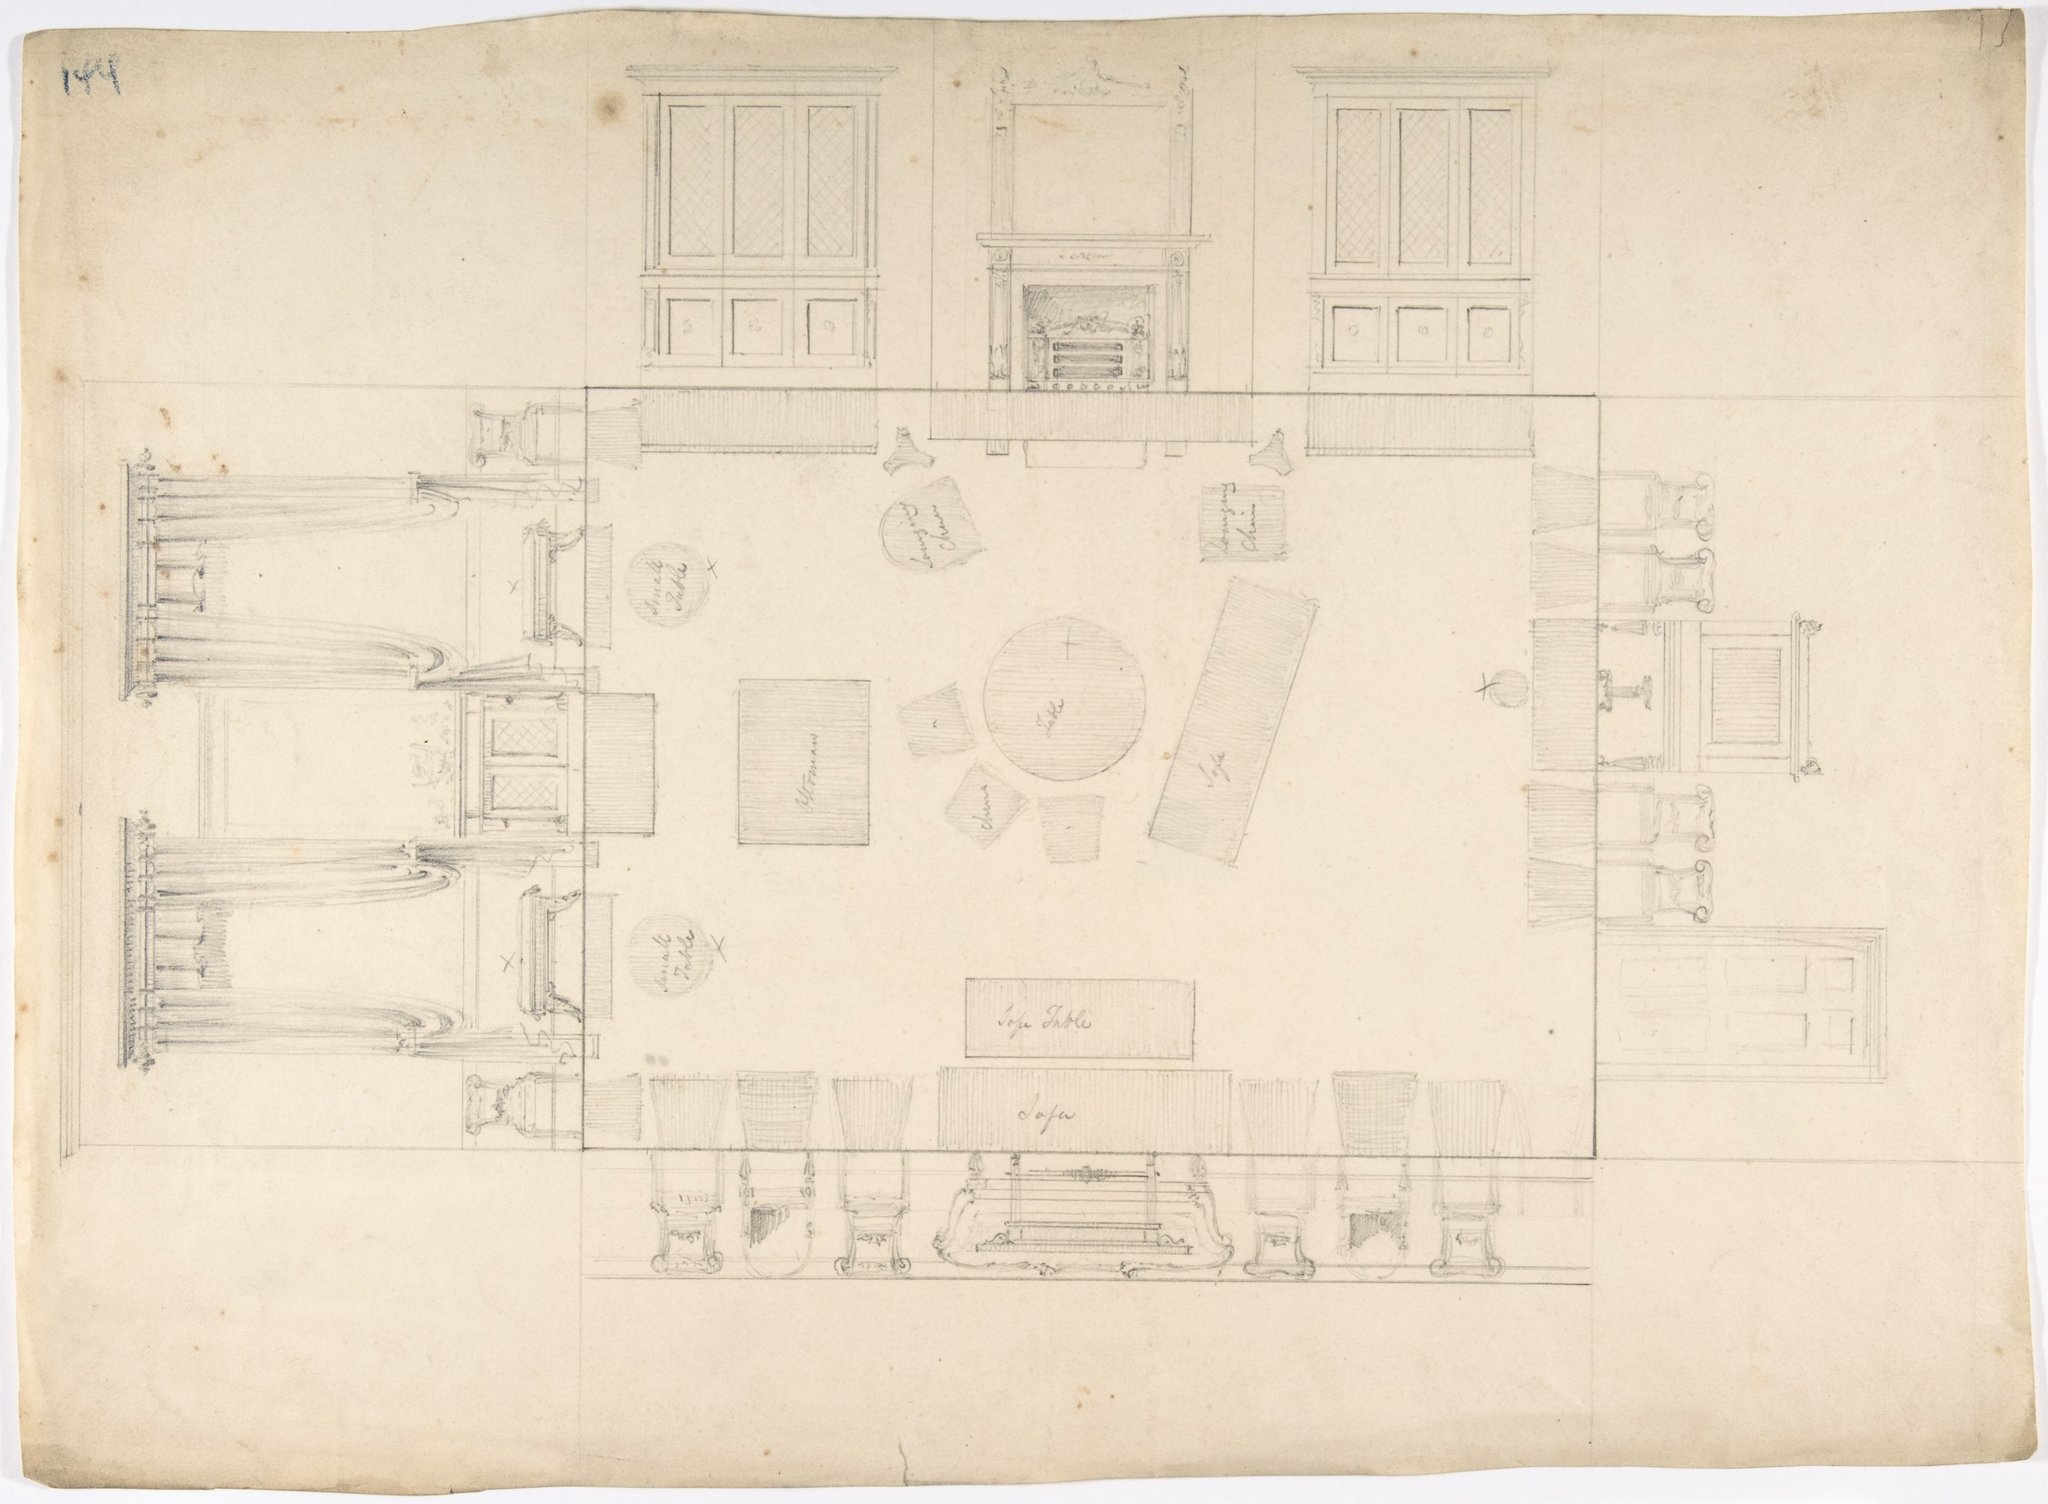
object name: drawing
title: Plan and Elevations of a Room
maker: anonymous, british, 19th century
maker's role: artist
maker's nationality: british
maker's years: 1800-1900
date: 1801-1833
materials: graphite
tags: architecture,interiors